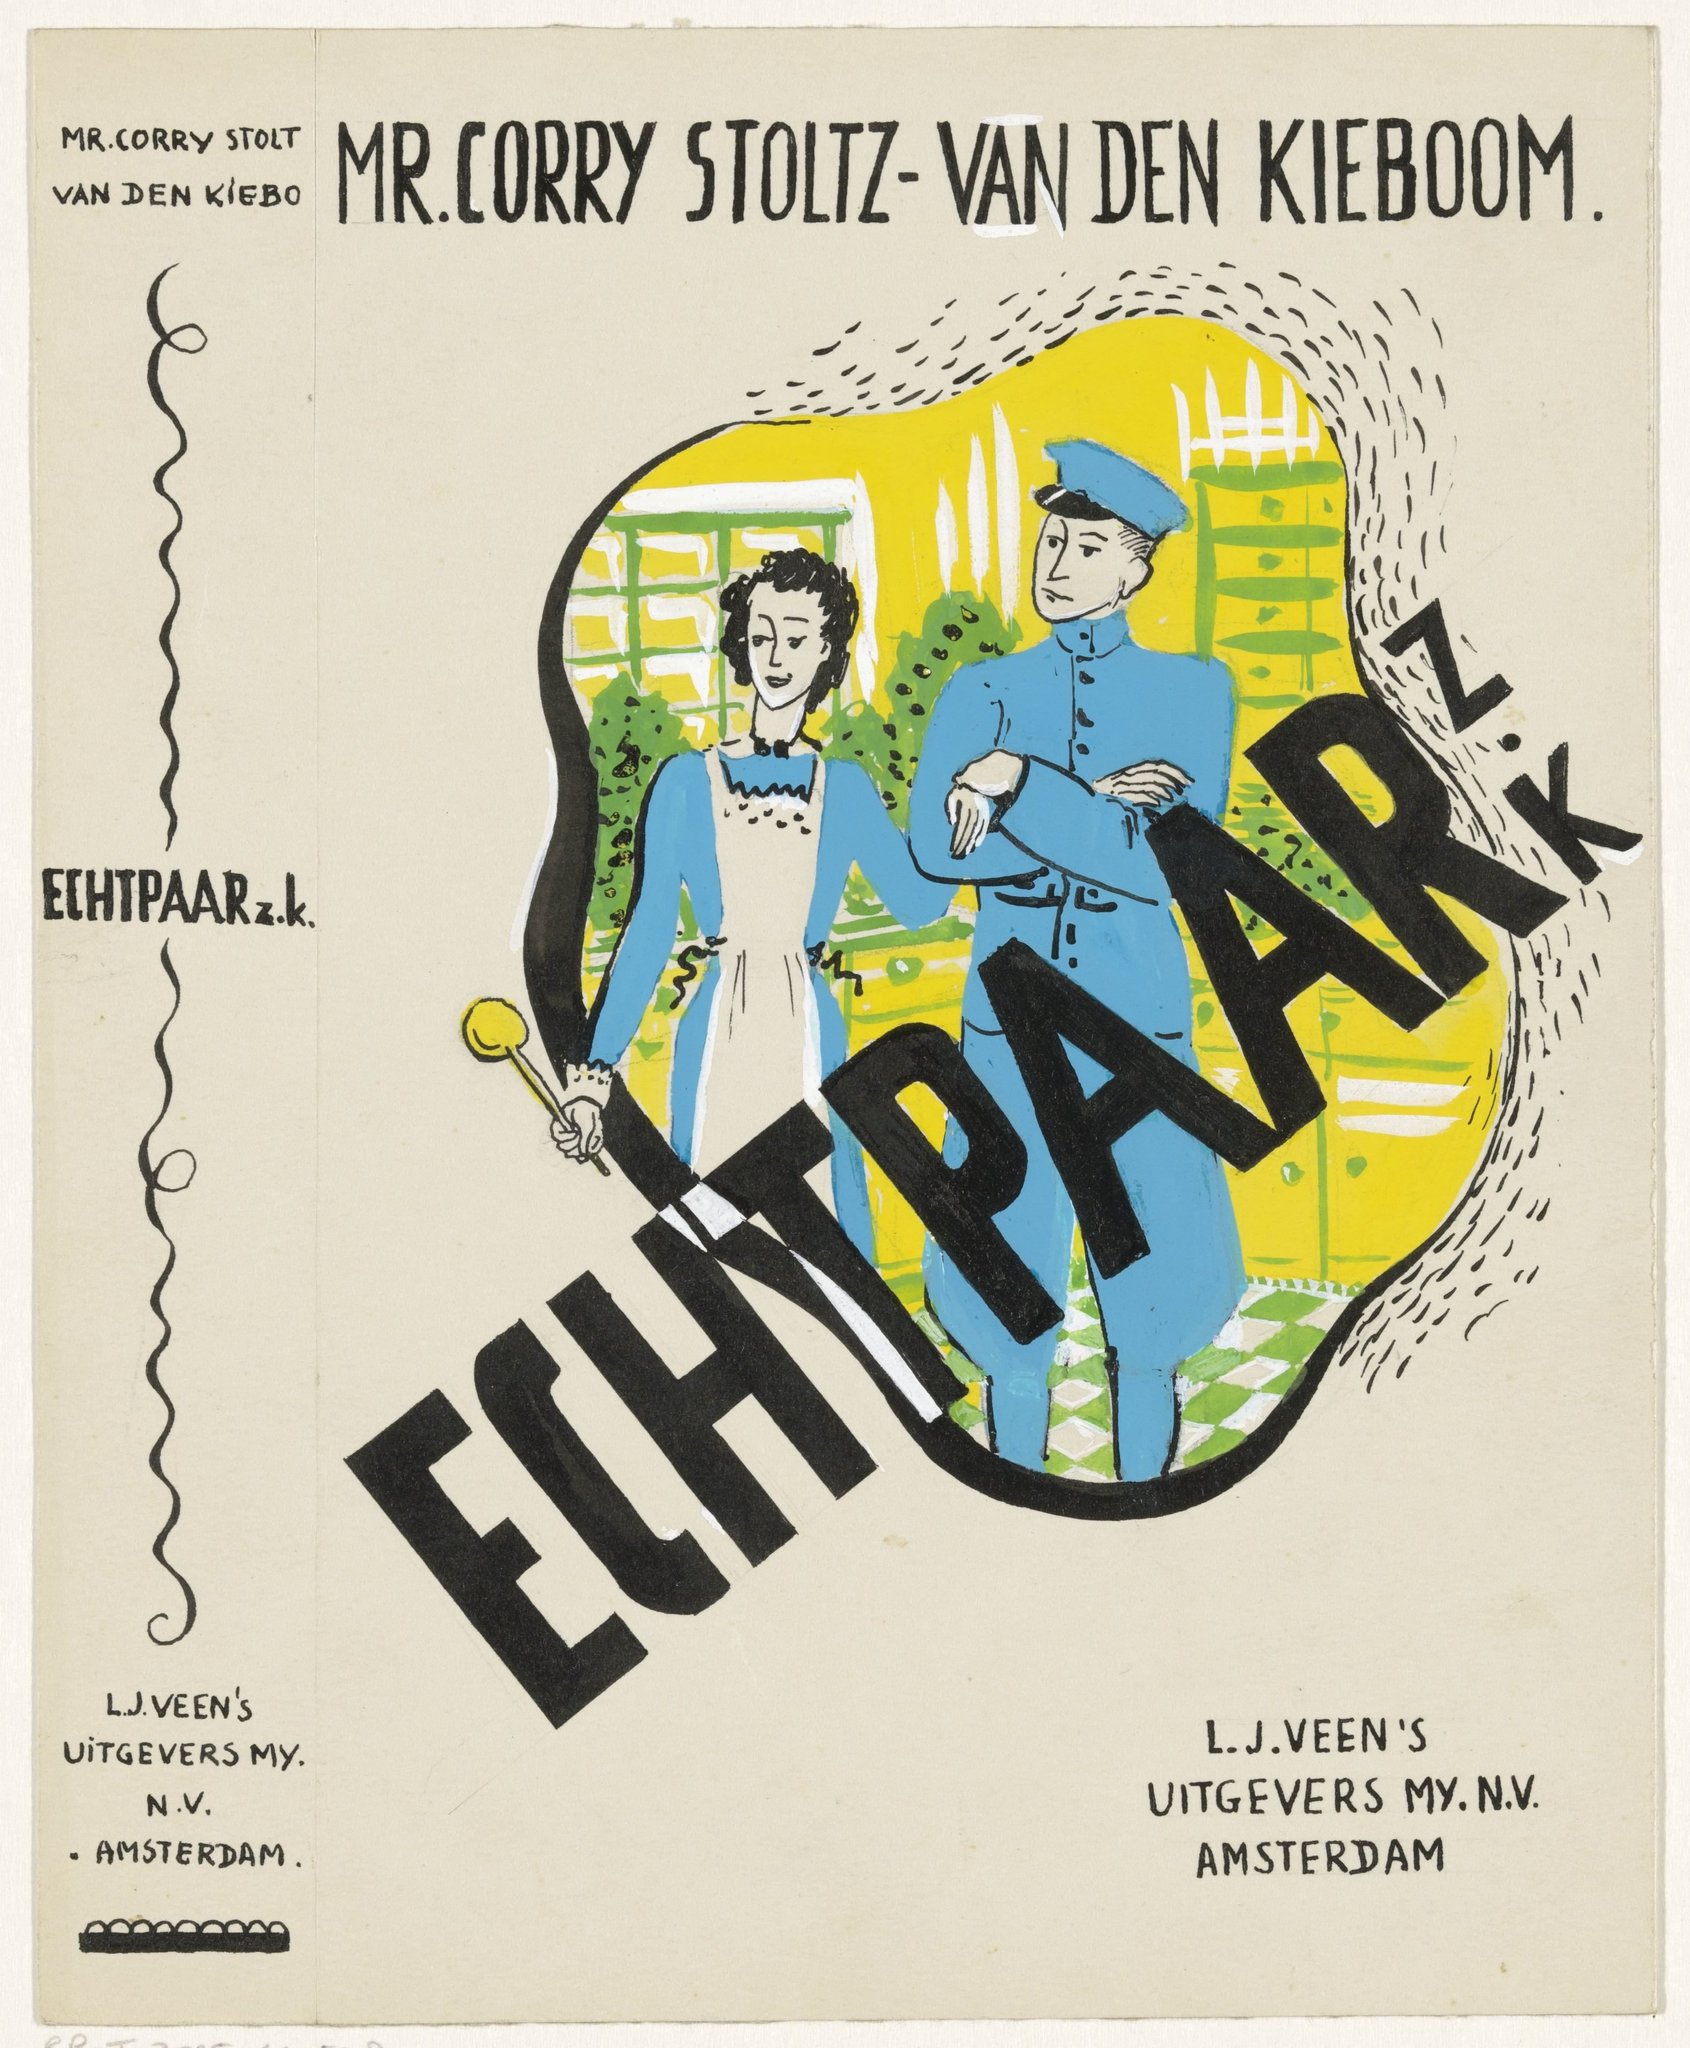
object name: drawing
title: Bandontwerp voor: Corry Stoltz-Van den Kieboom, Echtpaar z.k., 1936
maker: g. hagemeyer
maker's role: illustrator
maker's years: -1958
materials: paint, ink, paper, pencil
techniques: brush, pen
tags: kitchen, (military) uniforms, apron (+ women's clothes), arm in arm (lovers)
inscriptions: collector's mark: Lugt 2228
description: Een echtpaar staat arm in arm in een keuken. De man draagt een uniform met pet en de vrouw een jurk en schort. Ze heeft een pollepel vast. De voorstelling is omsloten door een vloeiend kader. Op de boekrug twee krullende lijnen.